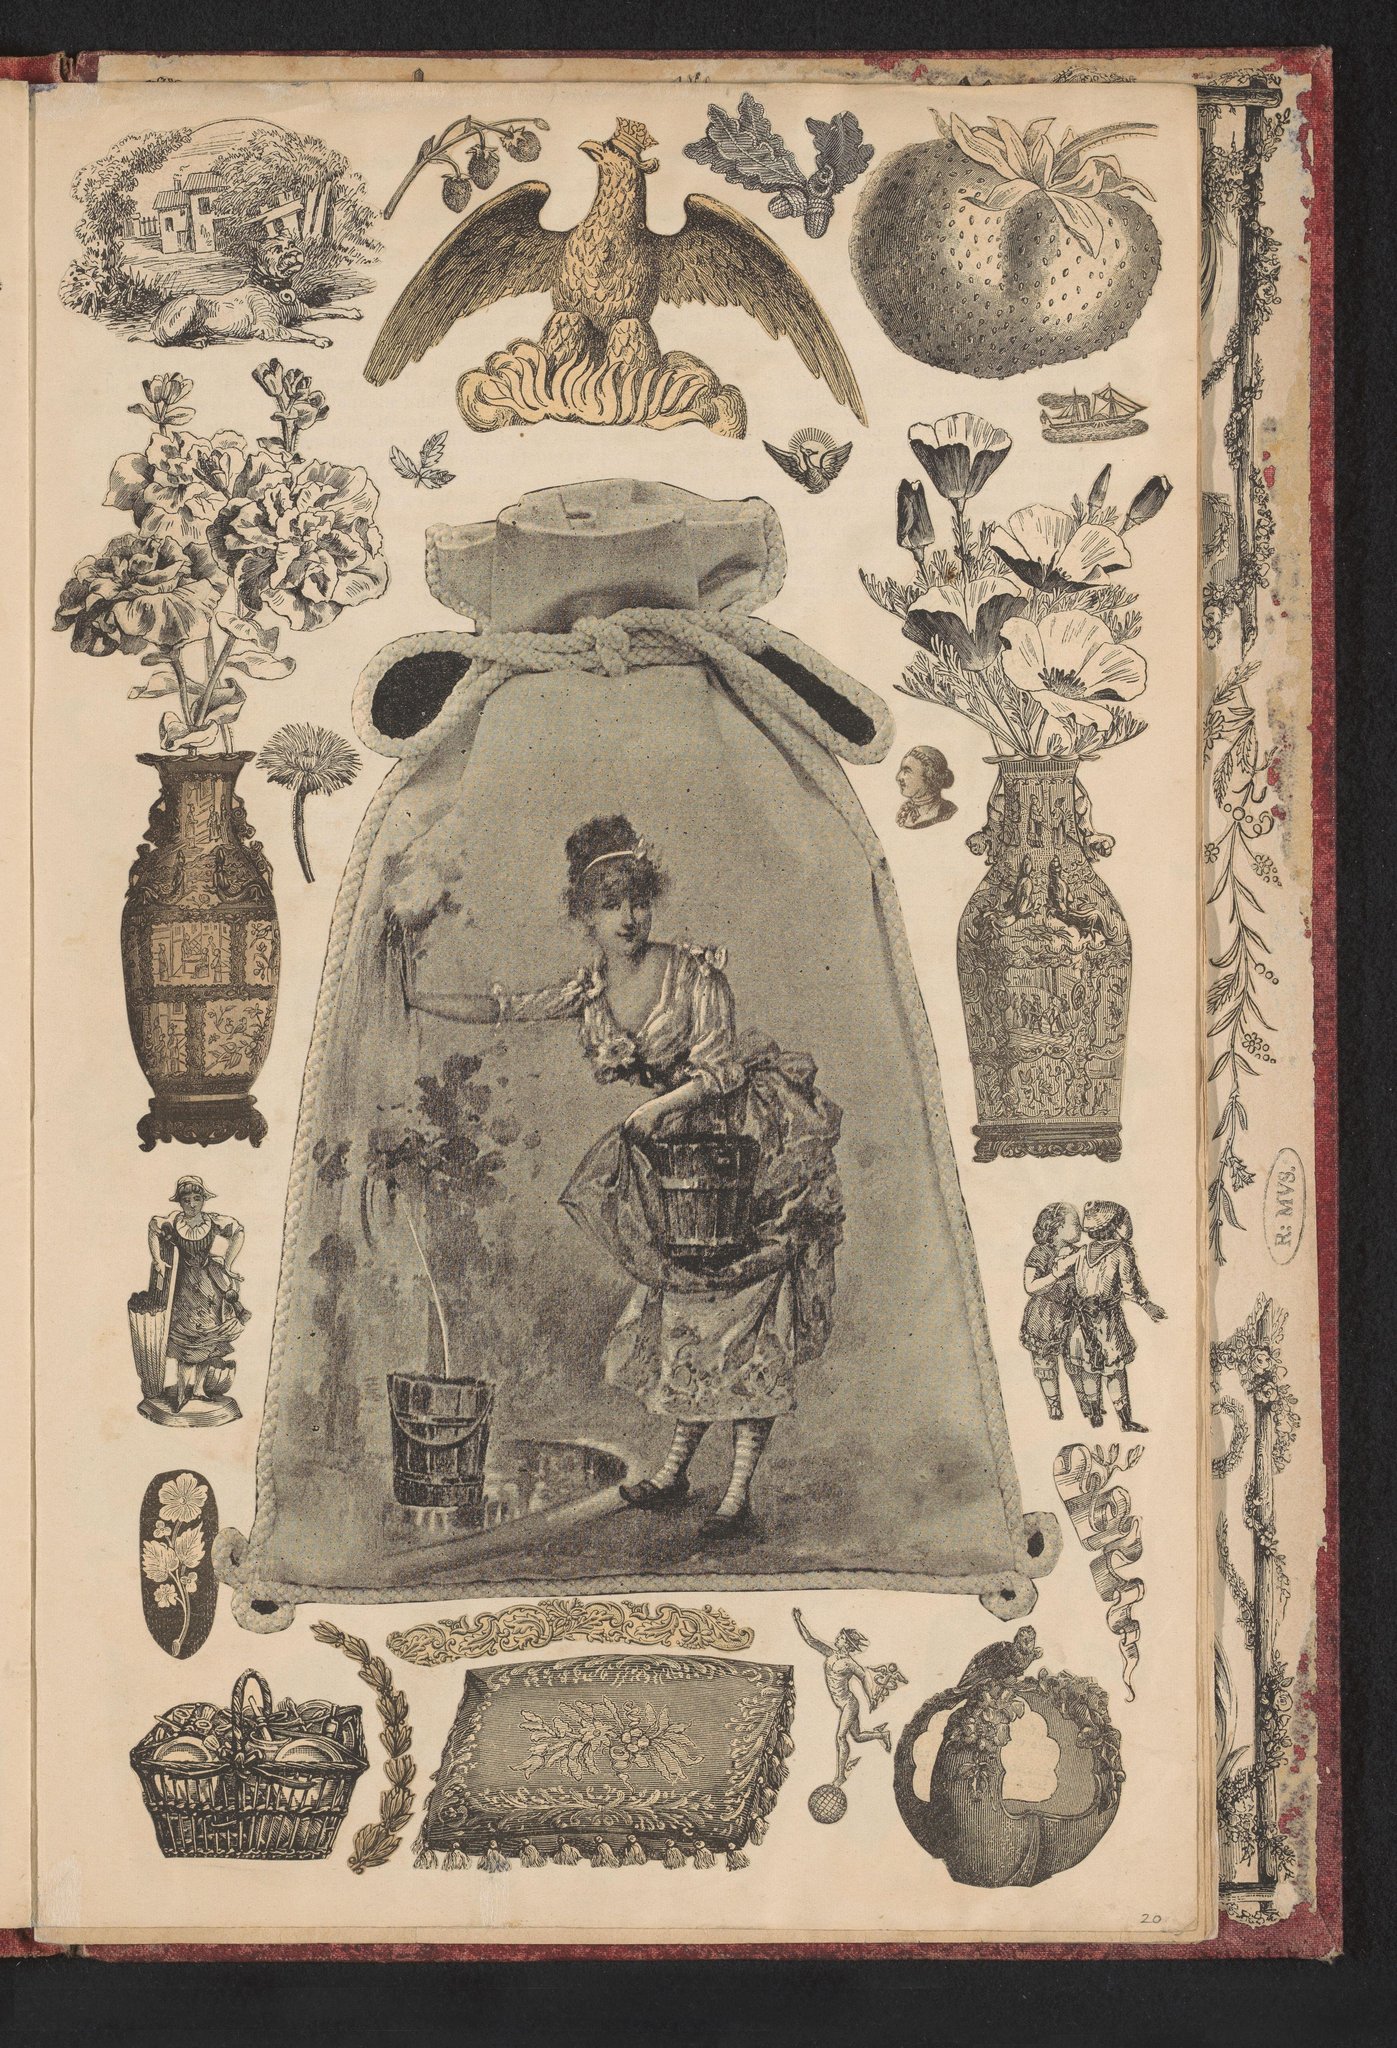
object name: print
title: Collage van uitgeknipte prenten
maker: Anonymous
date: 1870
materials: paper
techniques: engraving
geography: paris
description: Collage van uitgeknipte prenten. Onderdeel van een album met 32 bladen, aan beide zijden beplakt met uitgeknipte prenten, vermoedelijk afkomstig uit 19e-eeuwse tijdschiften.